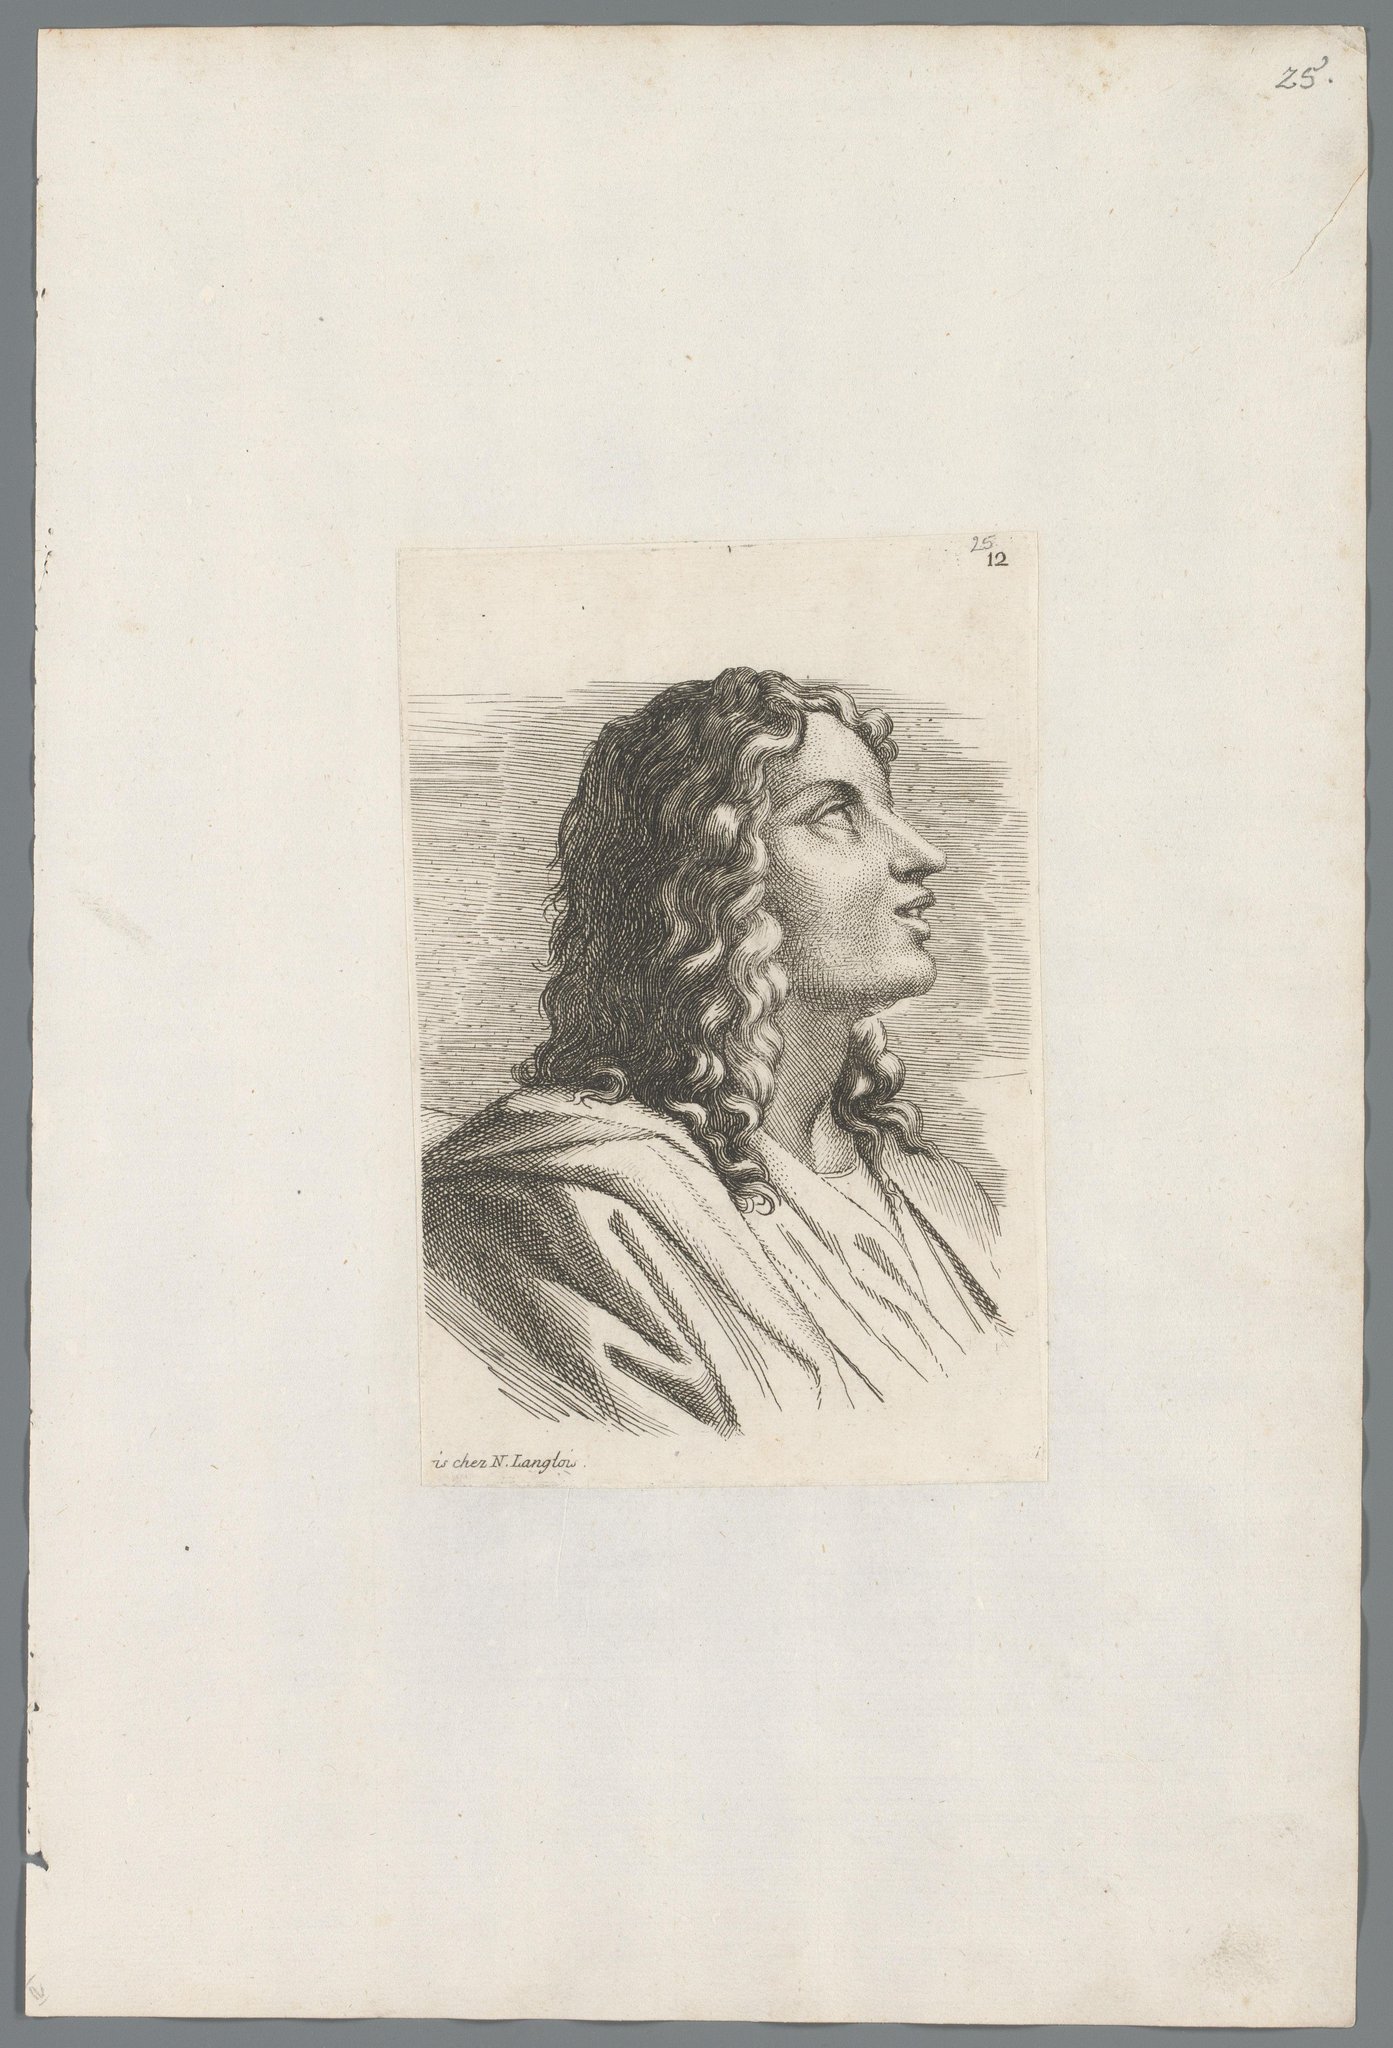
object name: print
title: Hoofd van een jongeman met lang krullend haar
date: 1650-1703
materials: paper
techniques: etching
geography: paris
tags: youth, adolescent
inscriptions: collector's mark: Lugt 2228, collector's mark: Lugt 2760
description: Prent uit een serie met op elke prent een hoofd uit een schilderij van Poussin.